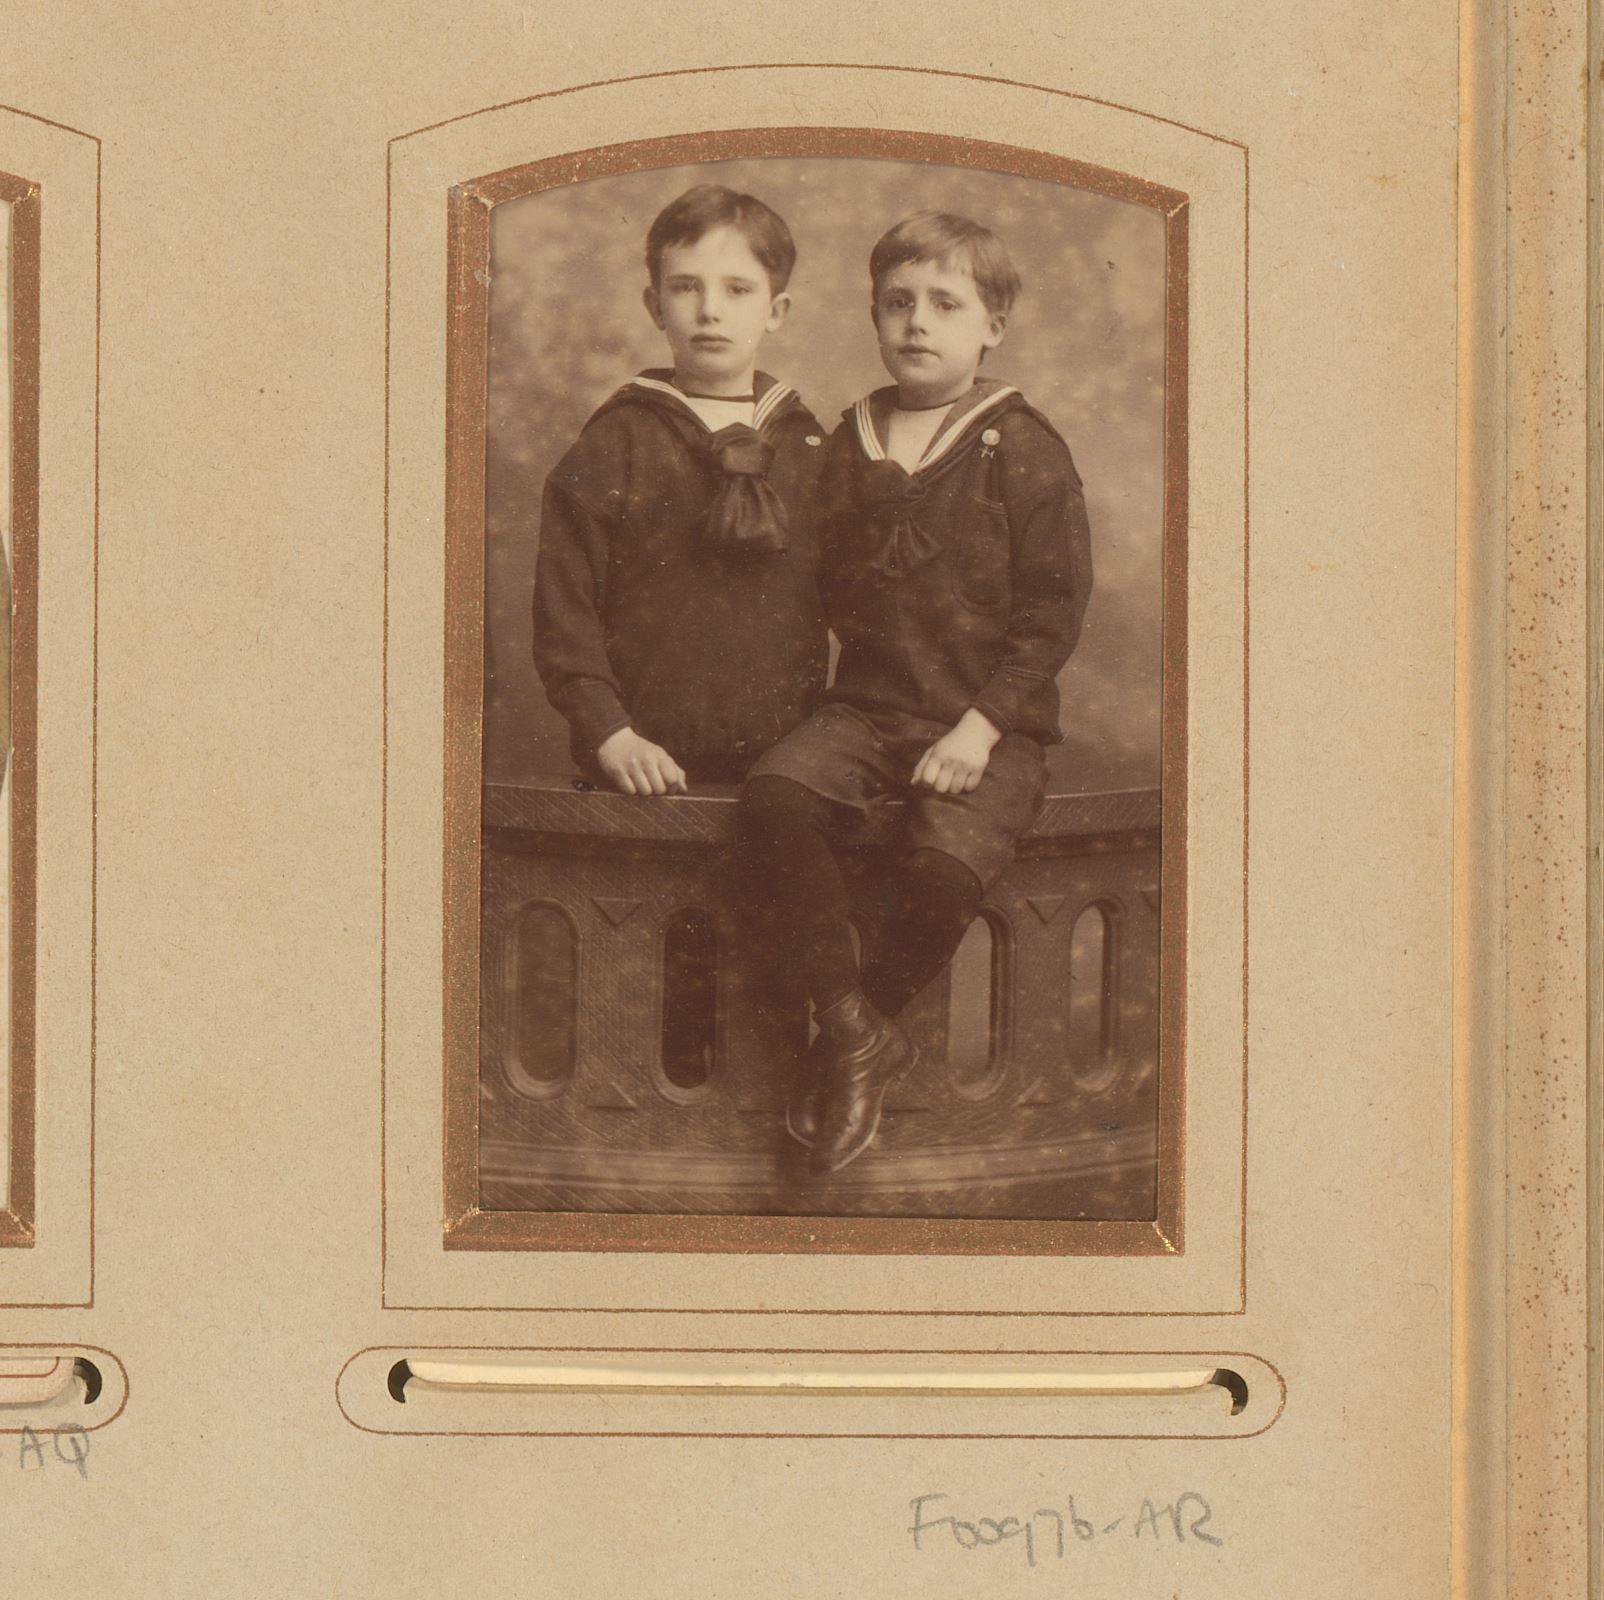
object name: photograph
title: Portret van twee jongens in matrozenpak, zittend op een balustrade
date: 1863-1903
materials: cardboard, photographic support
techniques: albumen print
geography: the hague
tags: boy (child between toddler and youth) (+ two persons), historical persons, balustrade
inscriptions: inscription: ‘De Lavieter & Co./ PHOTOGRAPHES DE LA COUR./ AGRANDISSEMENTS & PORTRAITS/ AU CHARBON EN TOUS GENRES./ La Haye/ 2A WILLEMSTR. 2A’